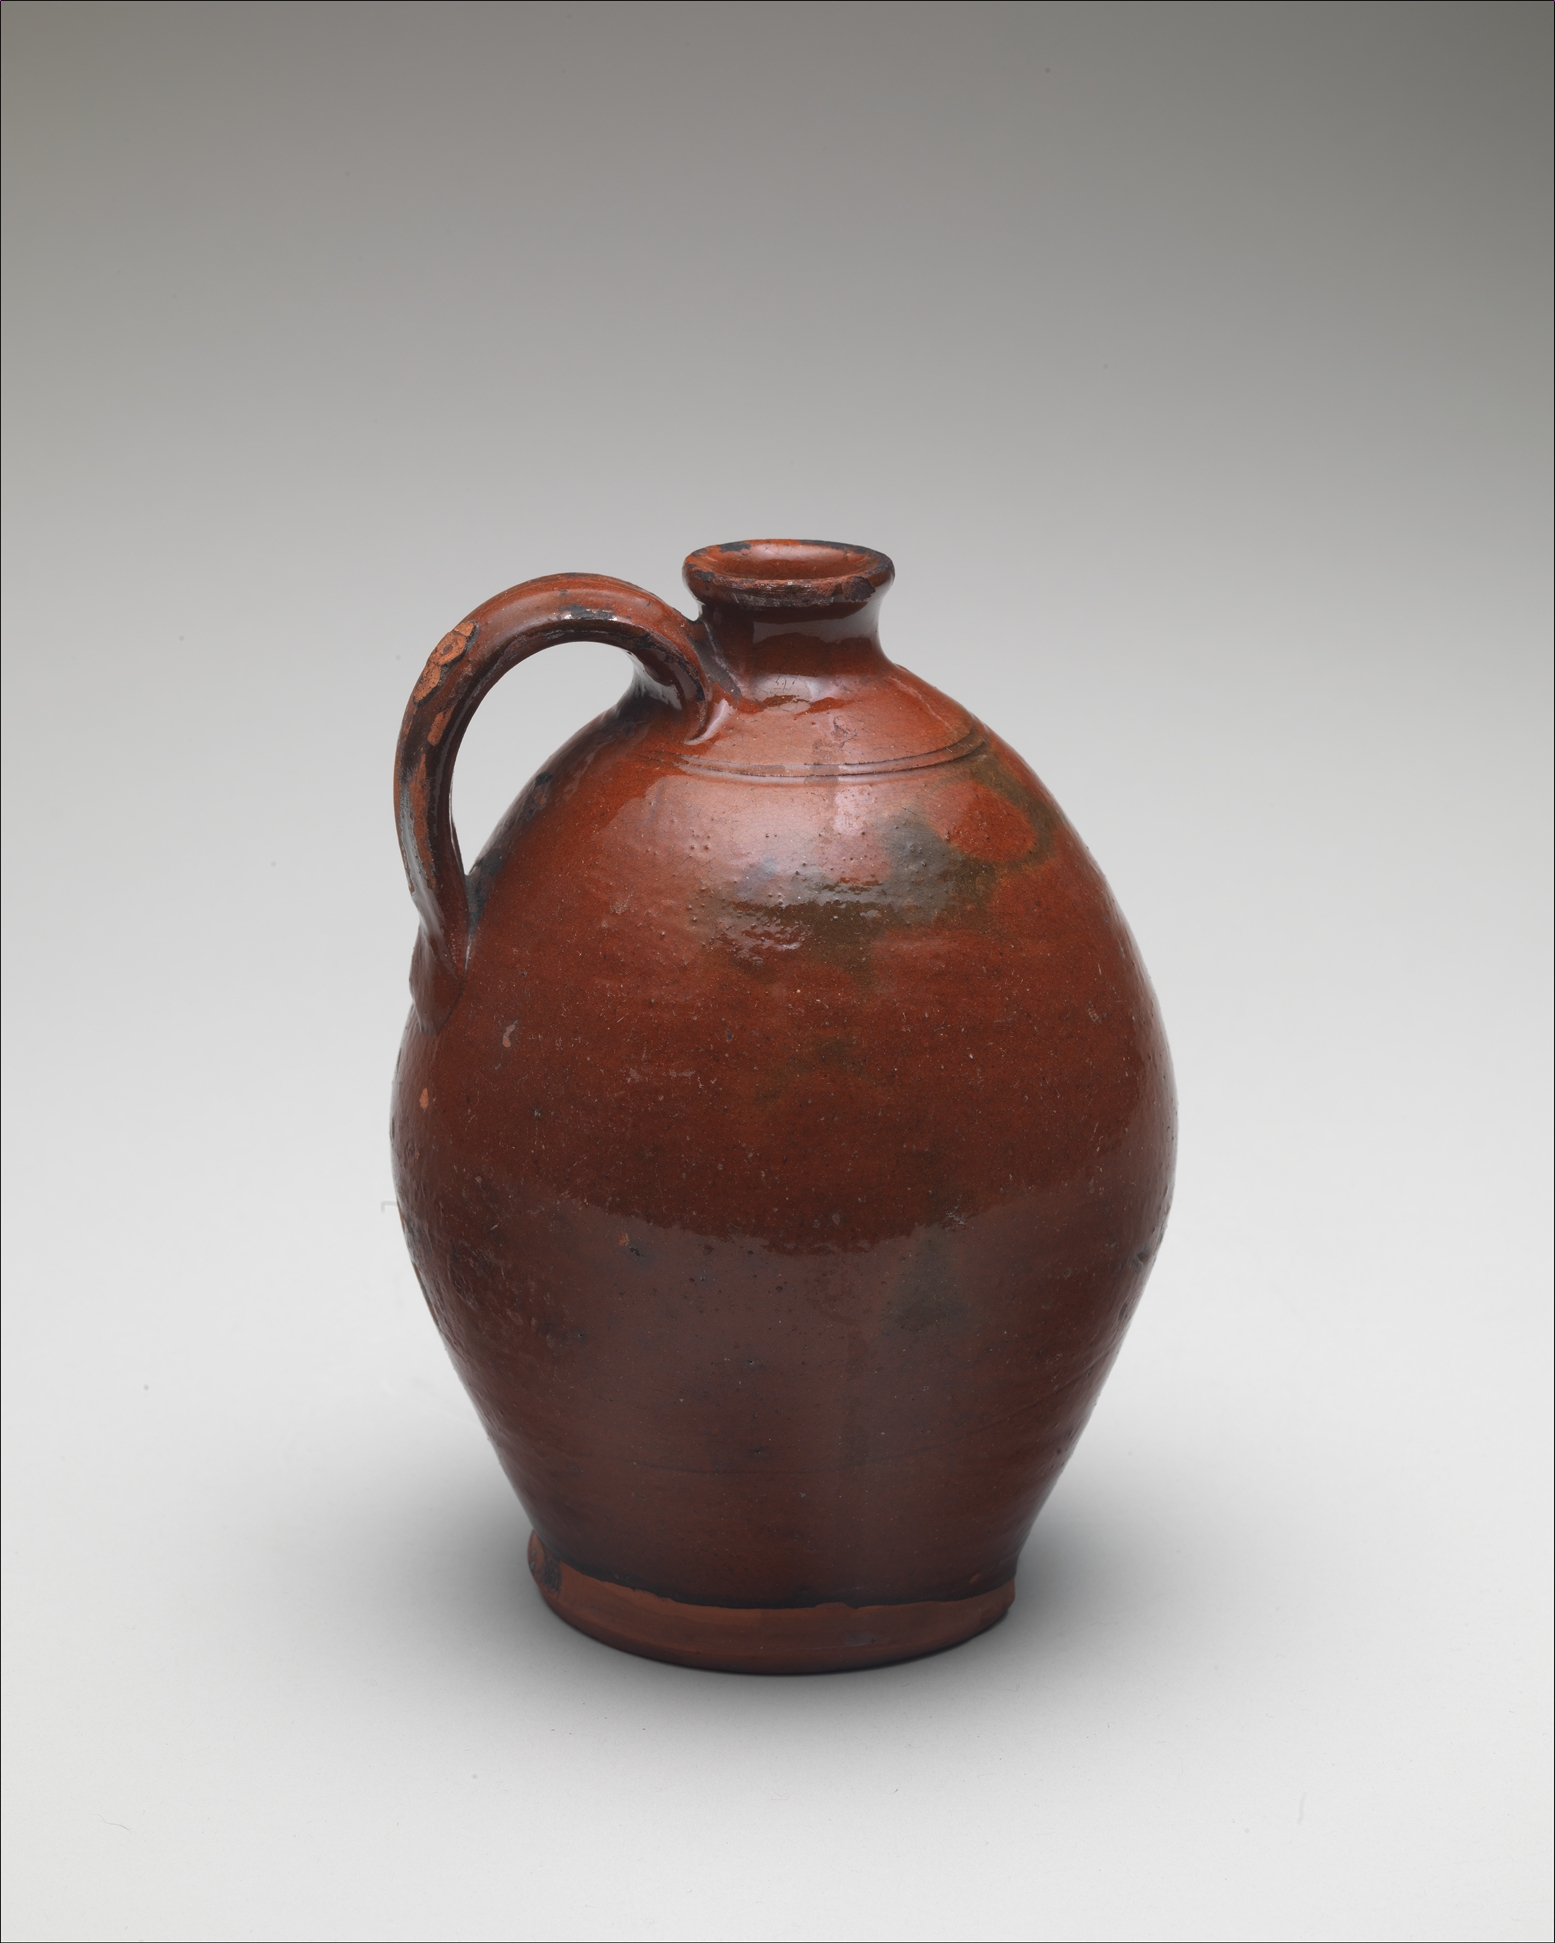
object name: jug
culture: american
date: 1800-1900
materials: earthenware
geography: united states